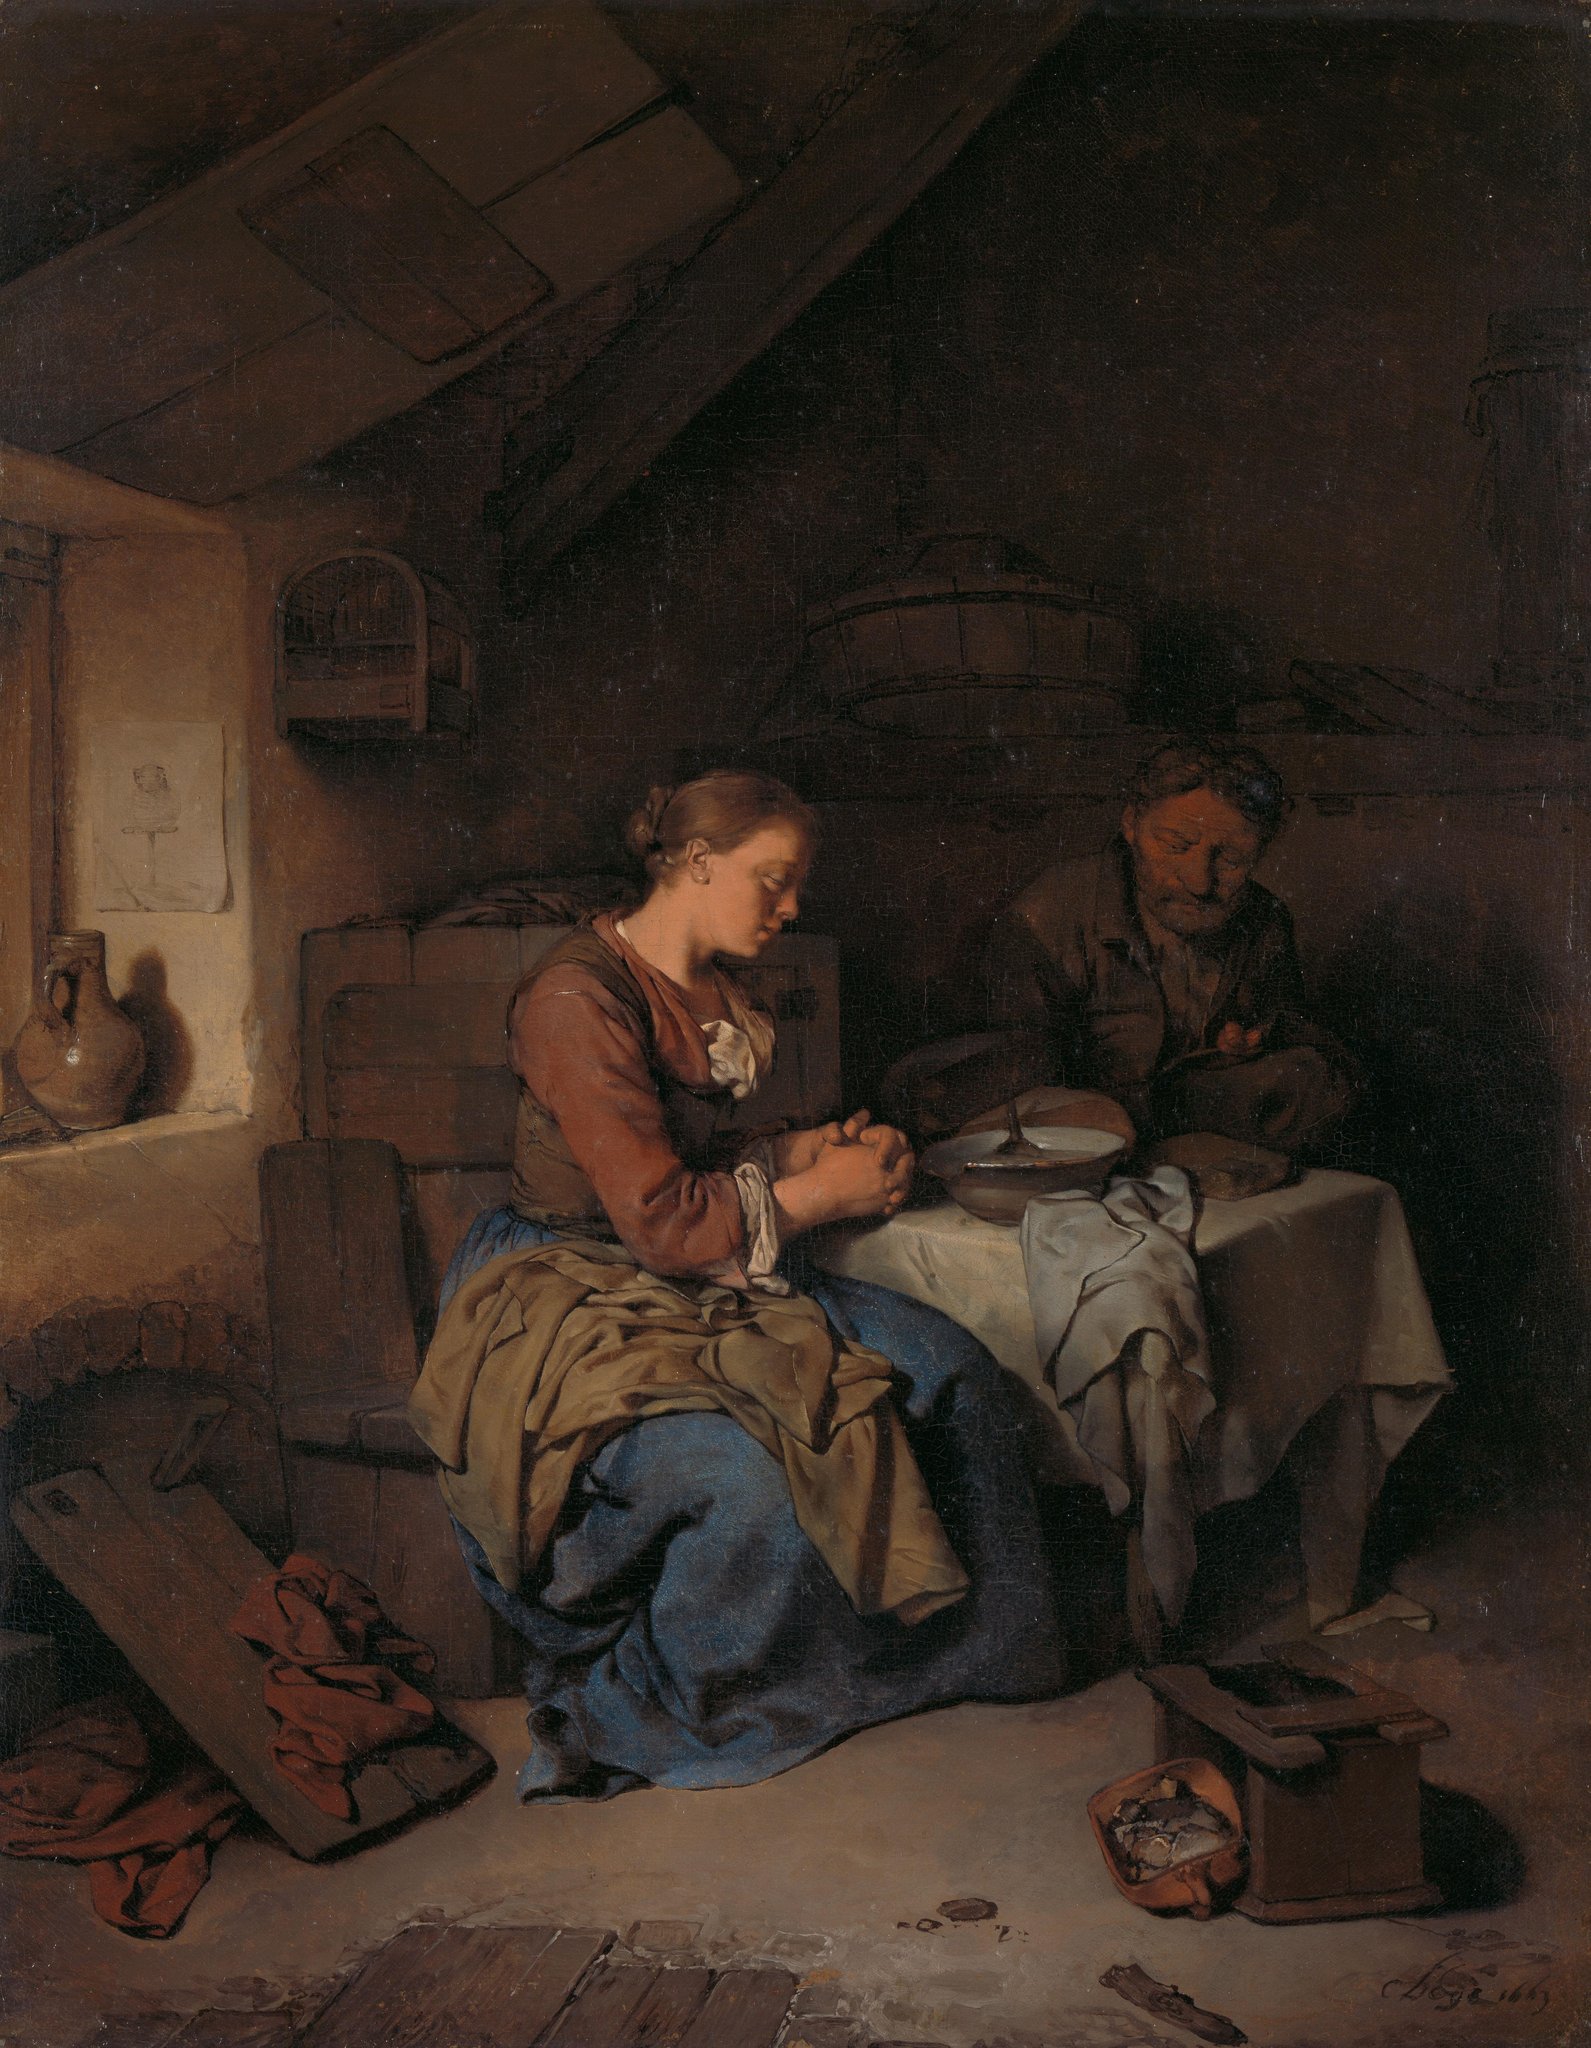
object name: painting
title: Saying Grace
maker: cornelis pietersz. bega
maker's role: draughtsman, painter, print maker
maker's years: 1631-1664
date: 1663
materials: canvas, oil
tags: foot-stove, container of ceramics: jar, jug, pot, vase, prayer at table, saying grace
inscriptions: signature and date: ‘c bega 1663’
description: Seated at a table in a run-down interior, an elderly man and a young woman pray before their meal. The painting contains a lesson that many Dutch Protestants learned at their mother’s knee: whether you are rich or poor, sick or healthy, be grateful for all you have, for it is a gift from God.